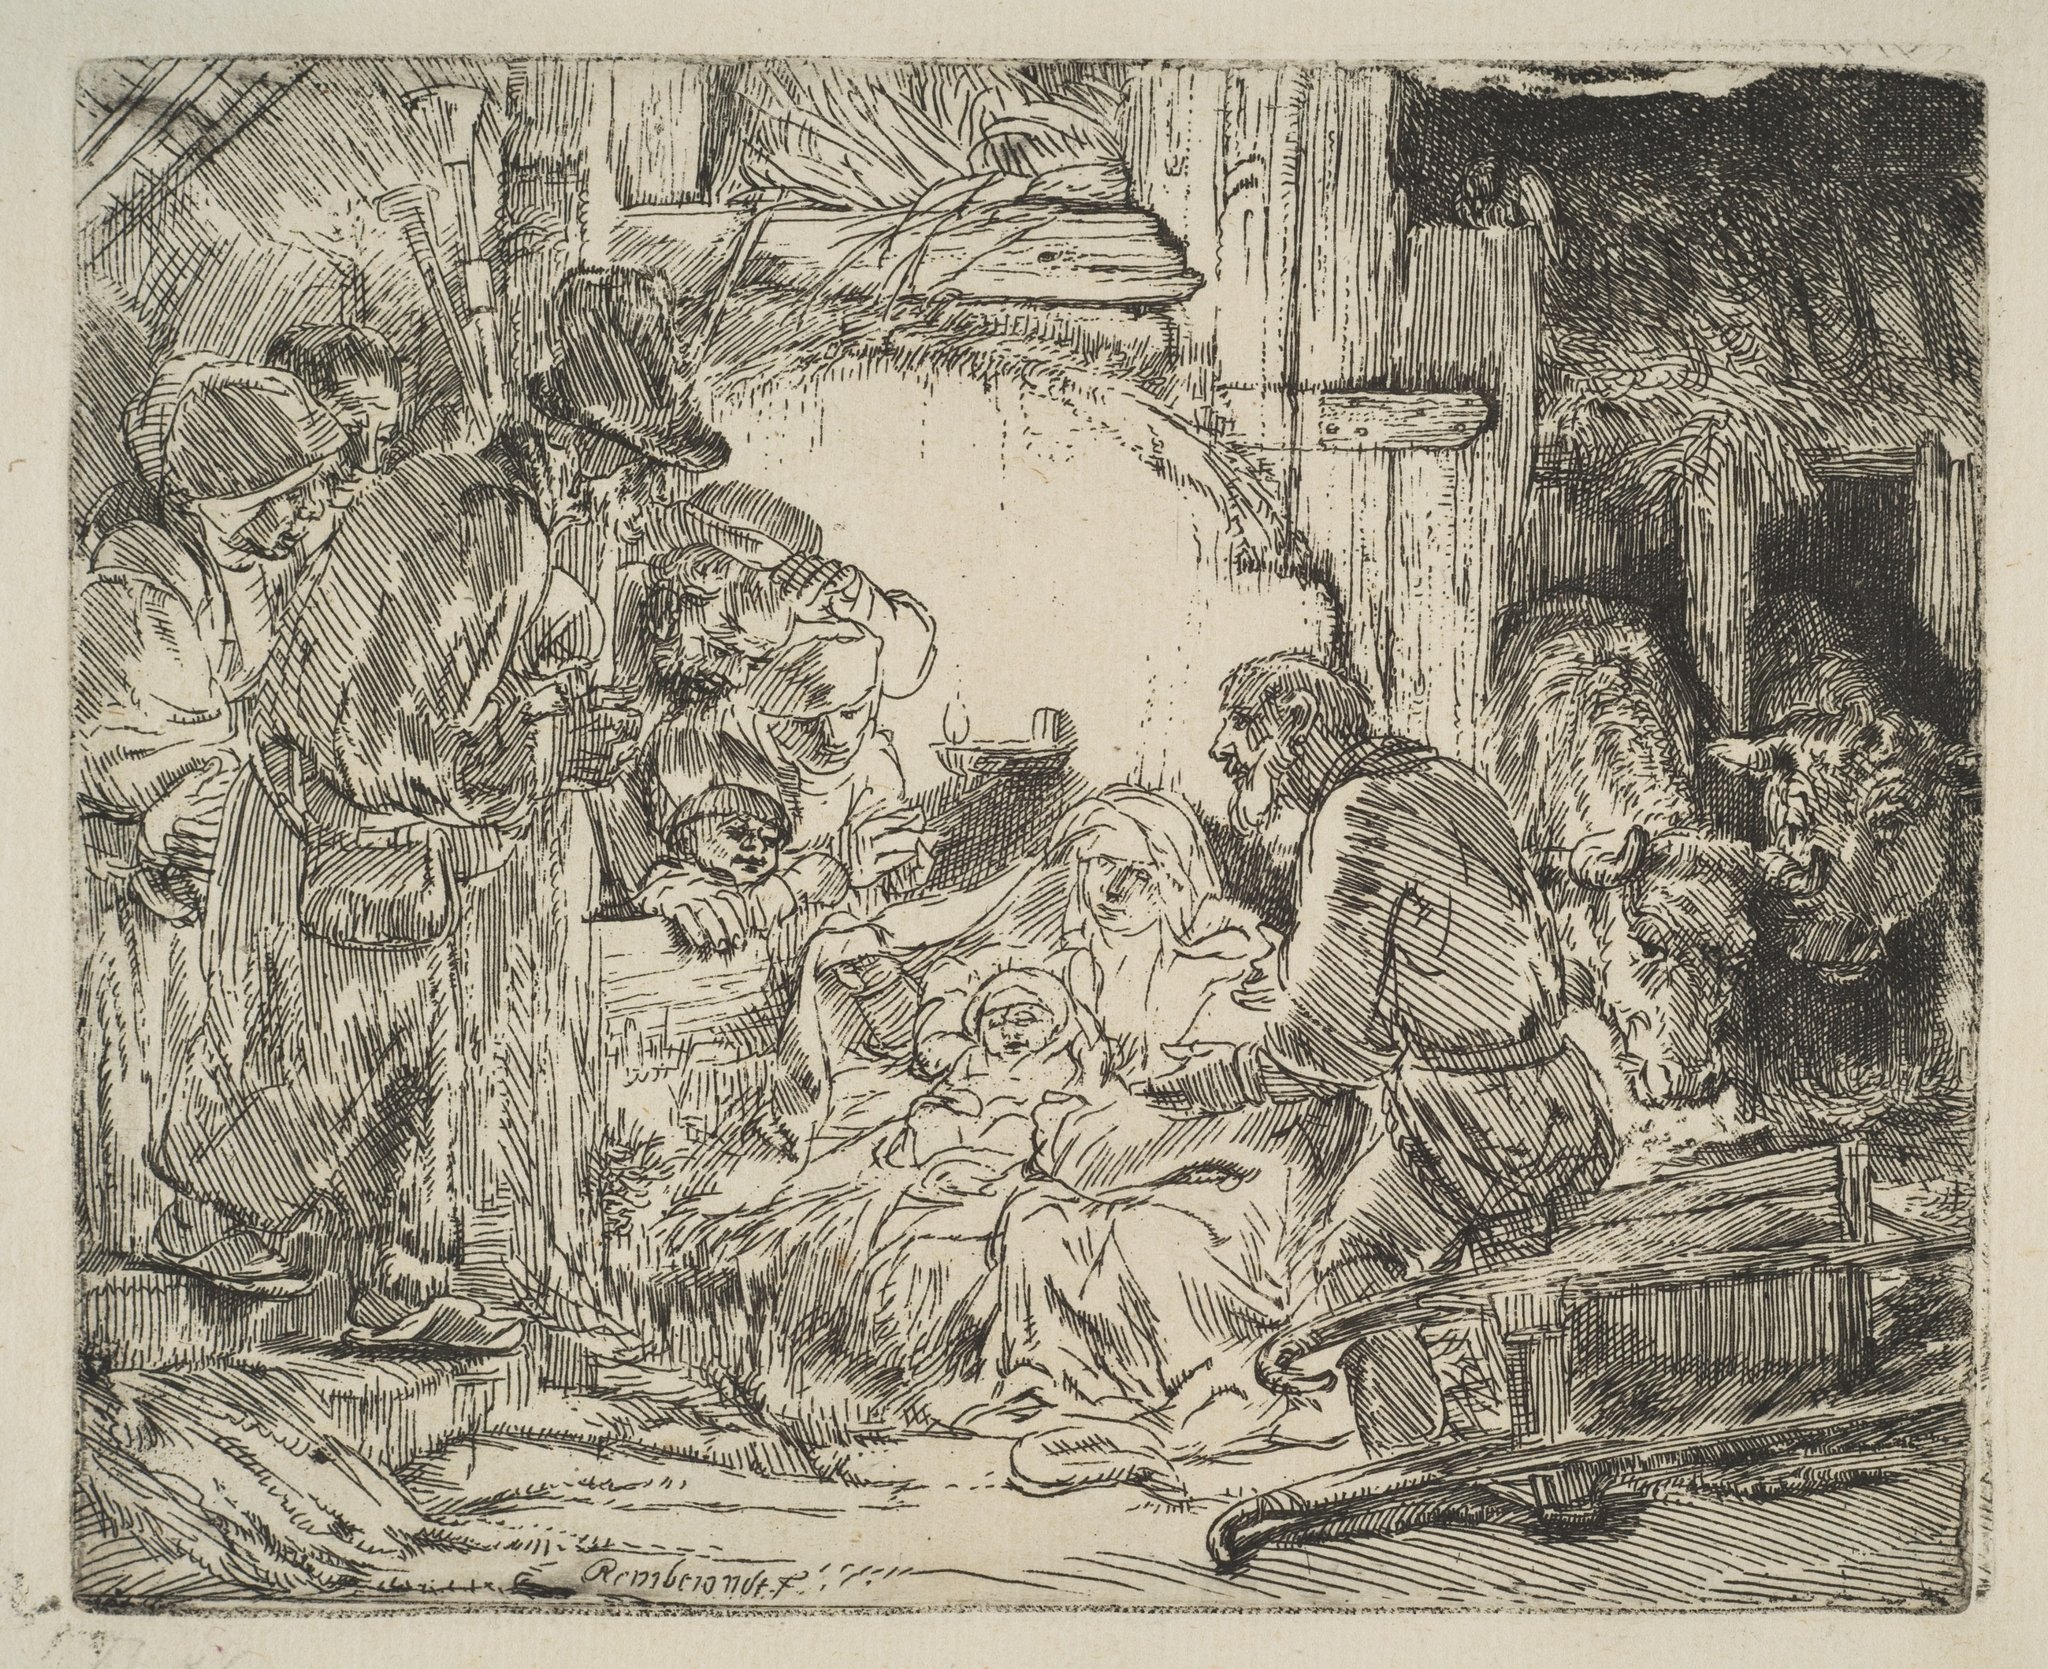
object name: print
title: The Adoration of the Shepherds, with the lamp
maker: rembrandt van rijn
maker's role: artist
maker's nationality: dutch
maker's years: 1606-1669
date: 1654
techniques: etching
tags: adoration of the shepherds